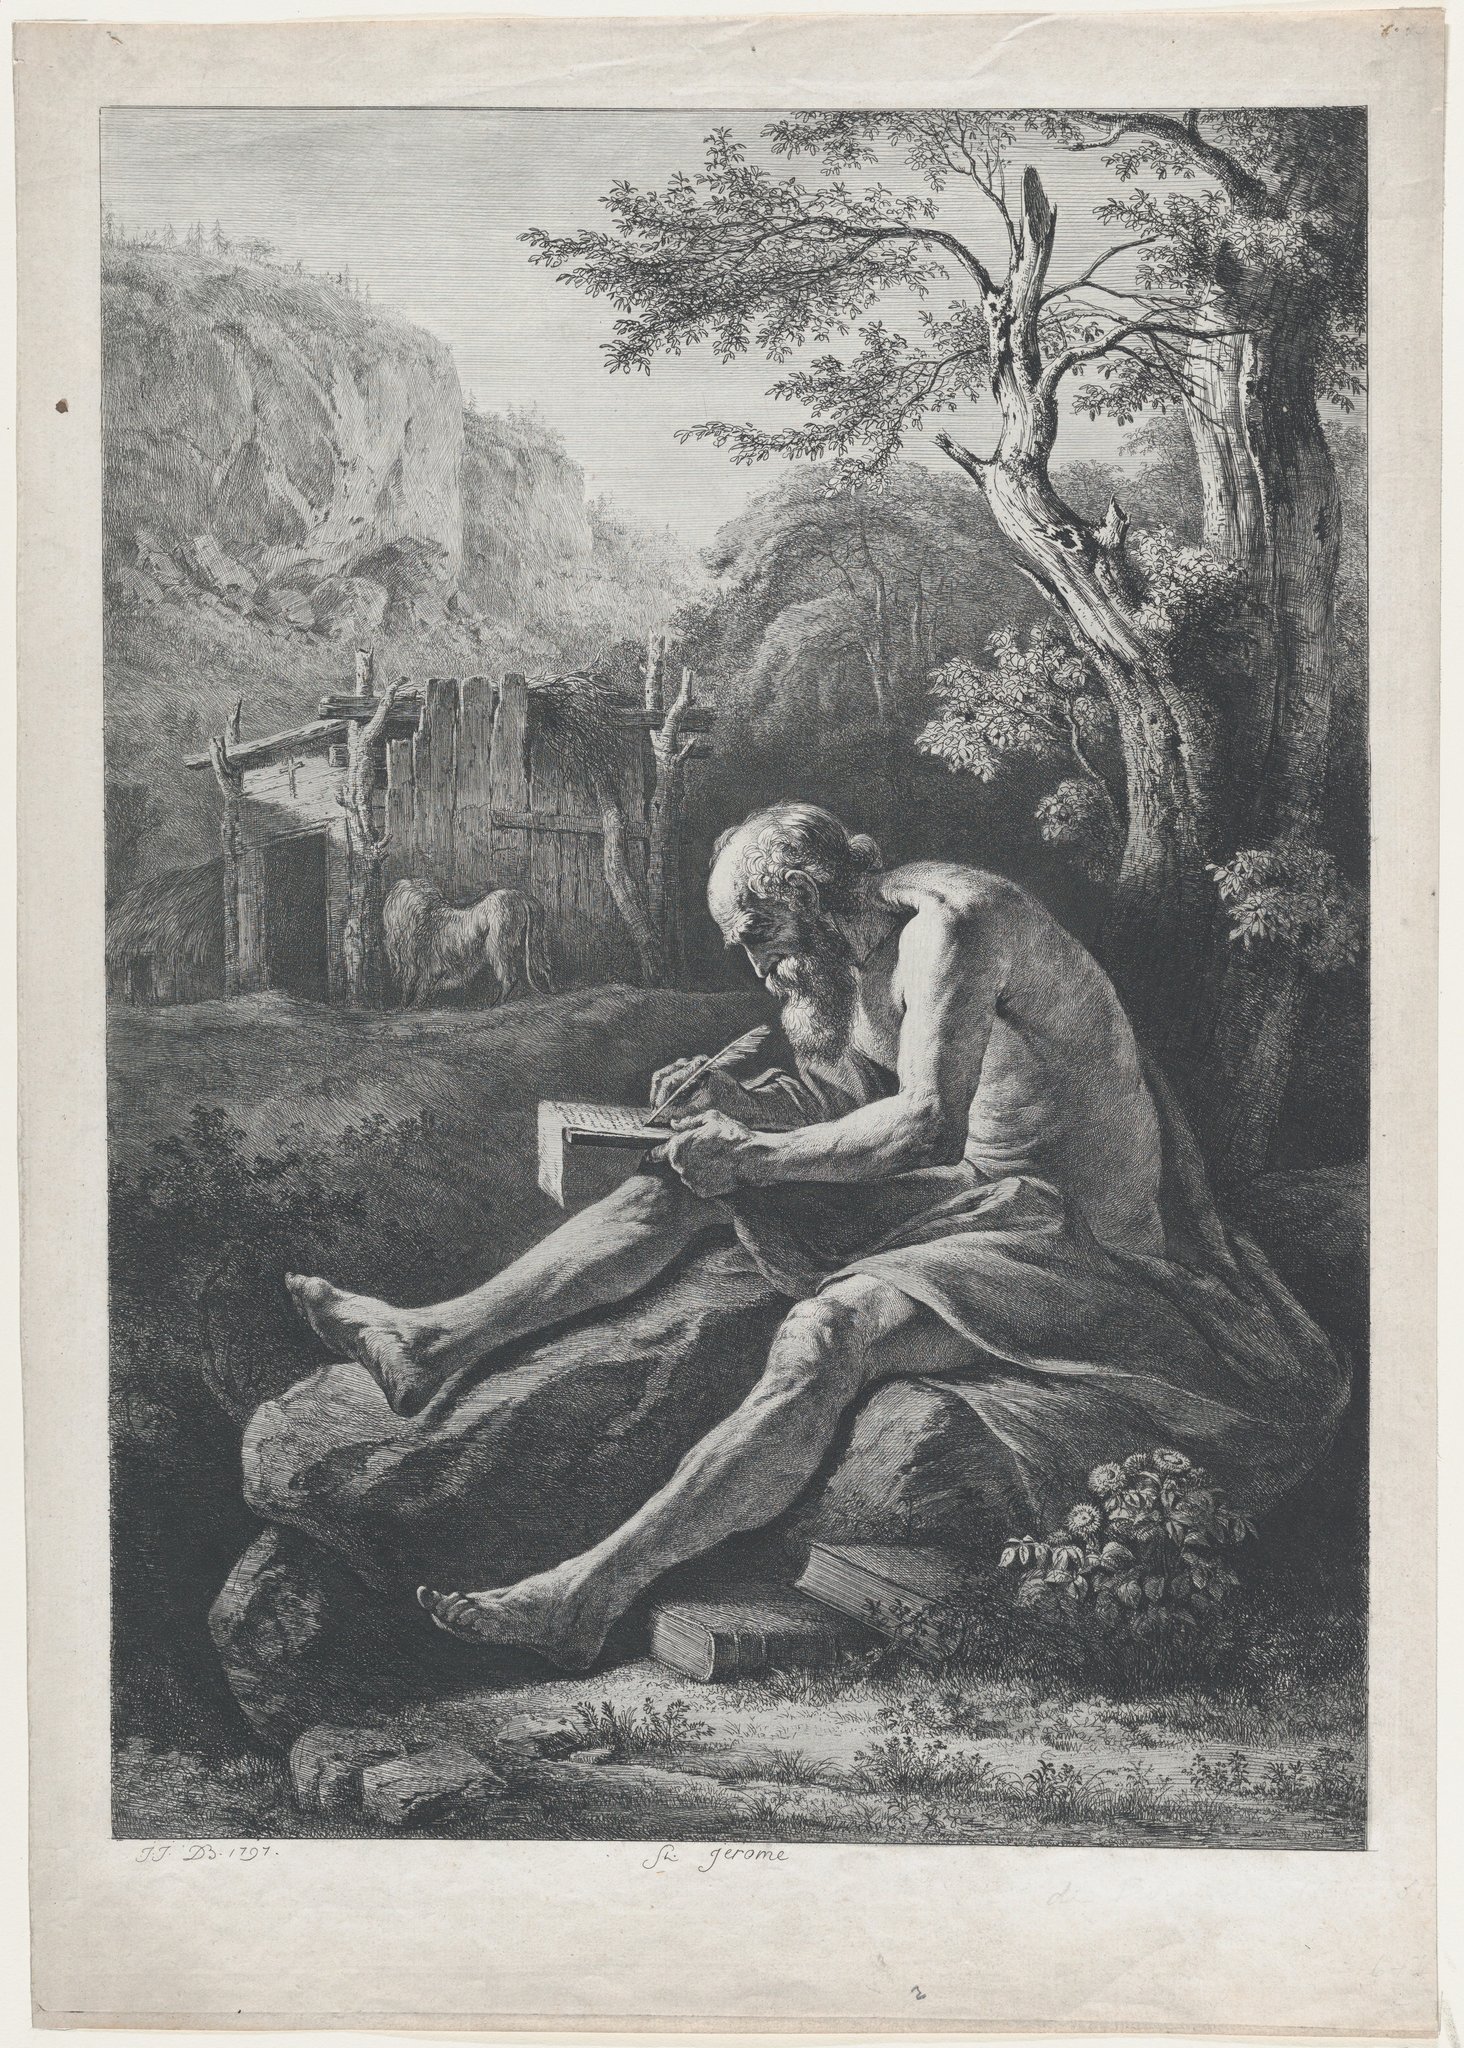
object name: print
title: St. Jerome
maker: jean jacques de boissieu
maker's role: artist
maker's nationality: french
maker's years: 1736-1810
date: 1797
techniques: engraving, drypoint, etching, roulette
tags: lions,saint jerome,writing